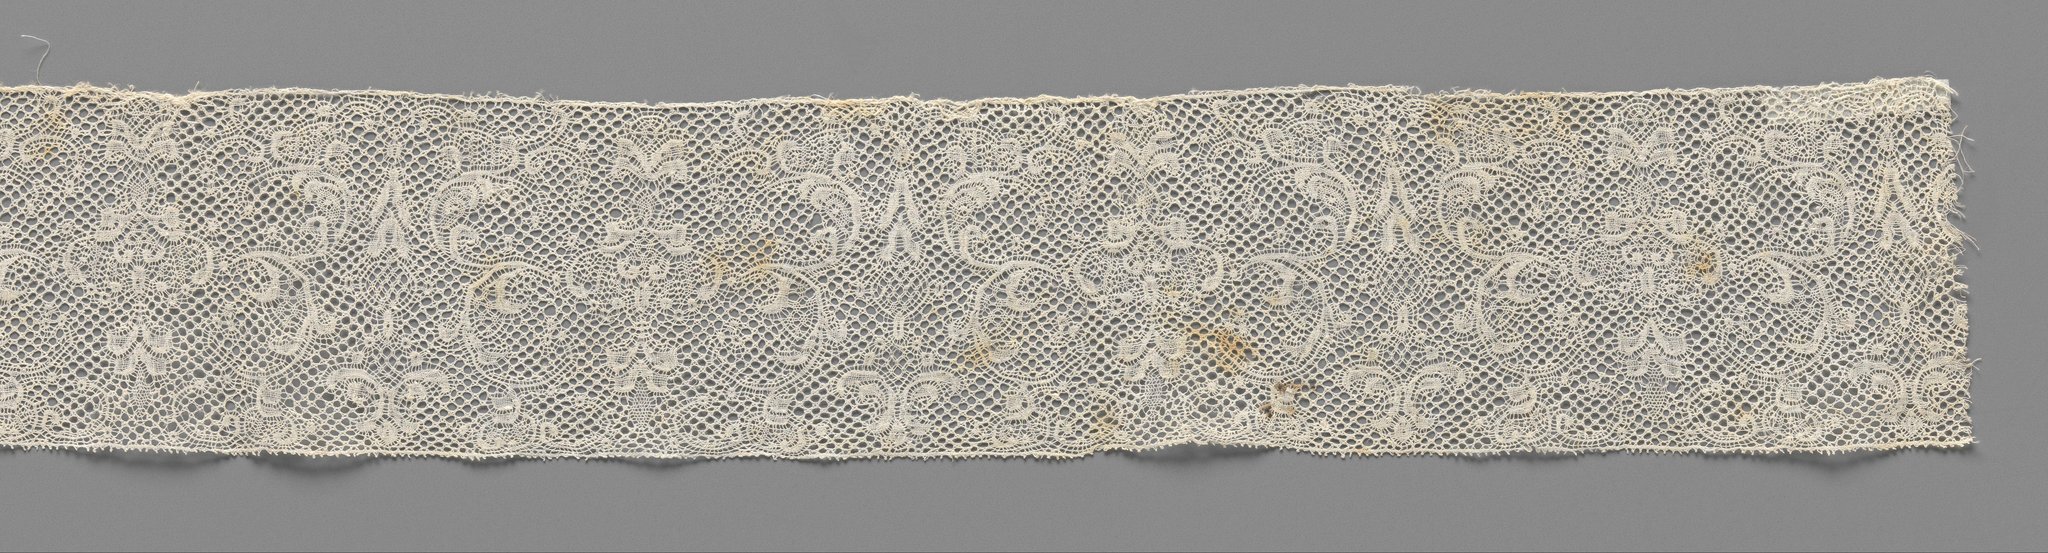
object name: strip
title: Strook kloskant met kandelabermotieven tussen c-voluten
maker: Anonymous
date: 1700-1720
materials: linen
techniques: lace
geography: binche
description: Strook naturelkleurige kloskant: Binche-kant. Het zich herhalende en symmetrische patroon bestaat uit twee verschillende kandelabermotieven geflankeerd door twee c-voluten, die op elkaar gestapeld de vorm van het cijfer 3 vormen, afwisselend wel en niet gespiegeld. De motieven zijn gemaakt in netslag en linnenslag met opengewerkte randjes. De motieven zijn met elkaar verbonden door een traliegrond, een vijfgaatjesgrond. Naast enkele losse sneewvlokken zijn hier en daar kleine oppervlakjes gevuld met siergronden, voornamelijk sneeuwvlokkengronden in verschillende variëteiten. De boven- en onderzijde van de strook zijn recht afgewerkt, waarbij de onderzijde is voorzien van picots. Eén korte zijde is afgewerkt met een zoompje.